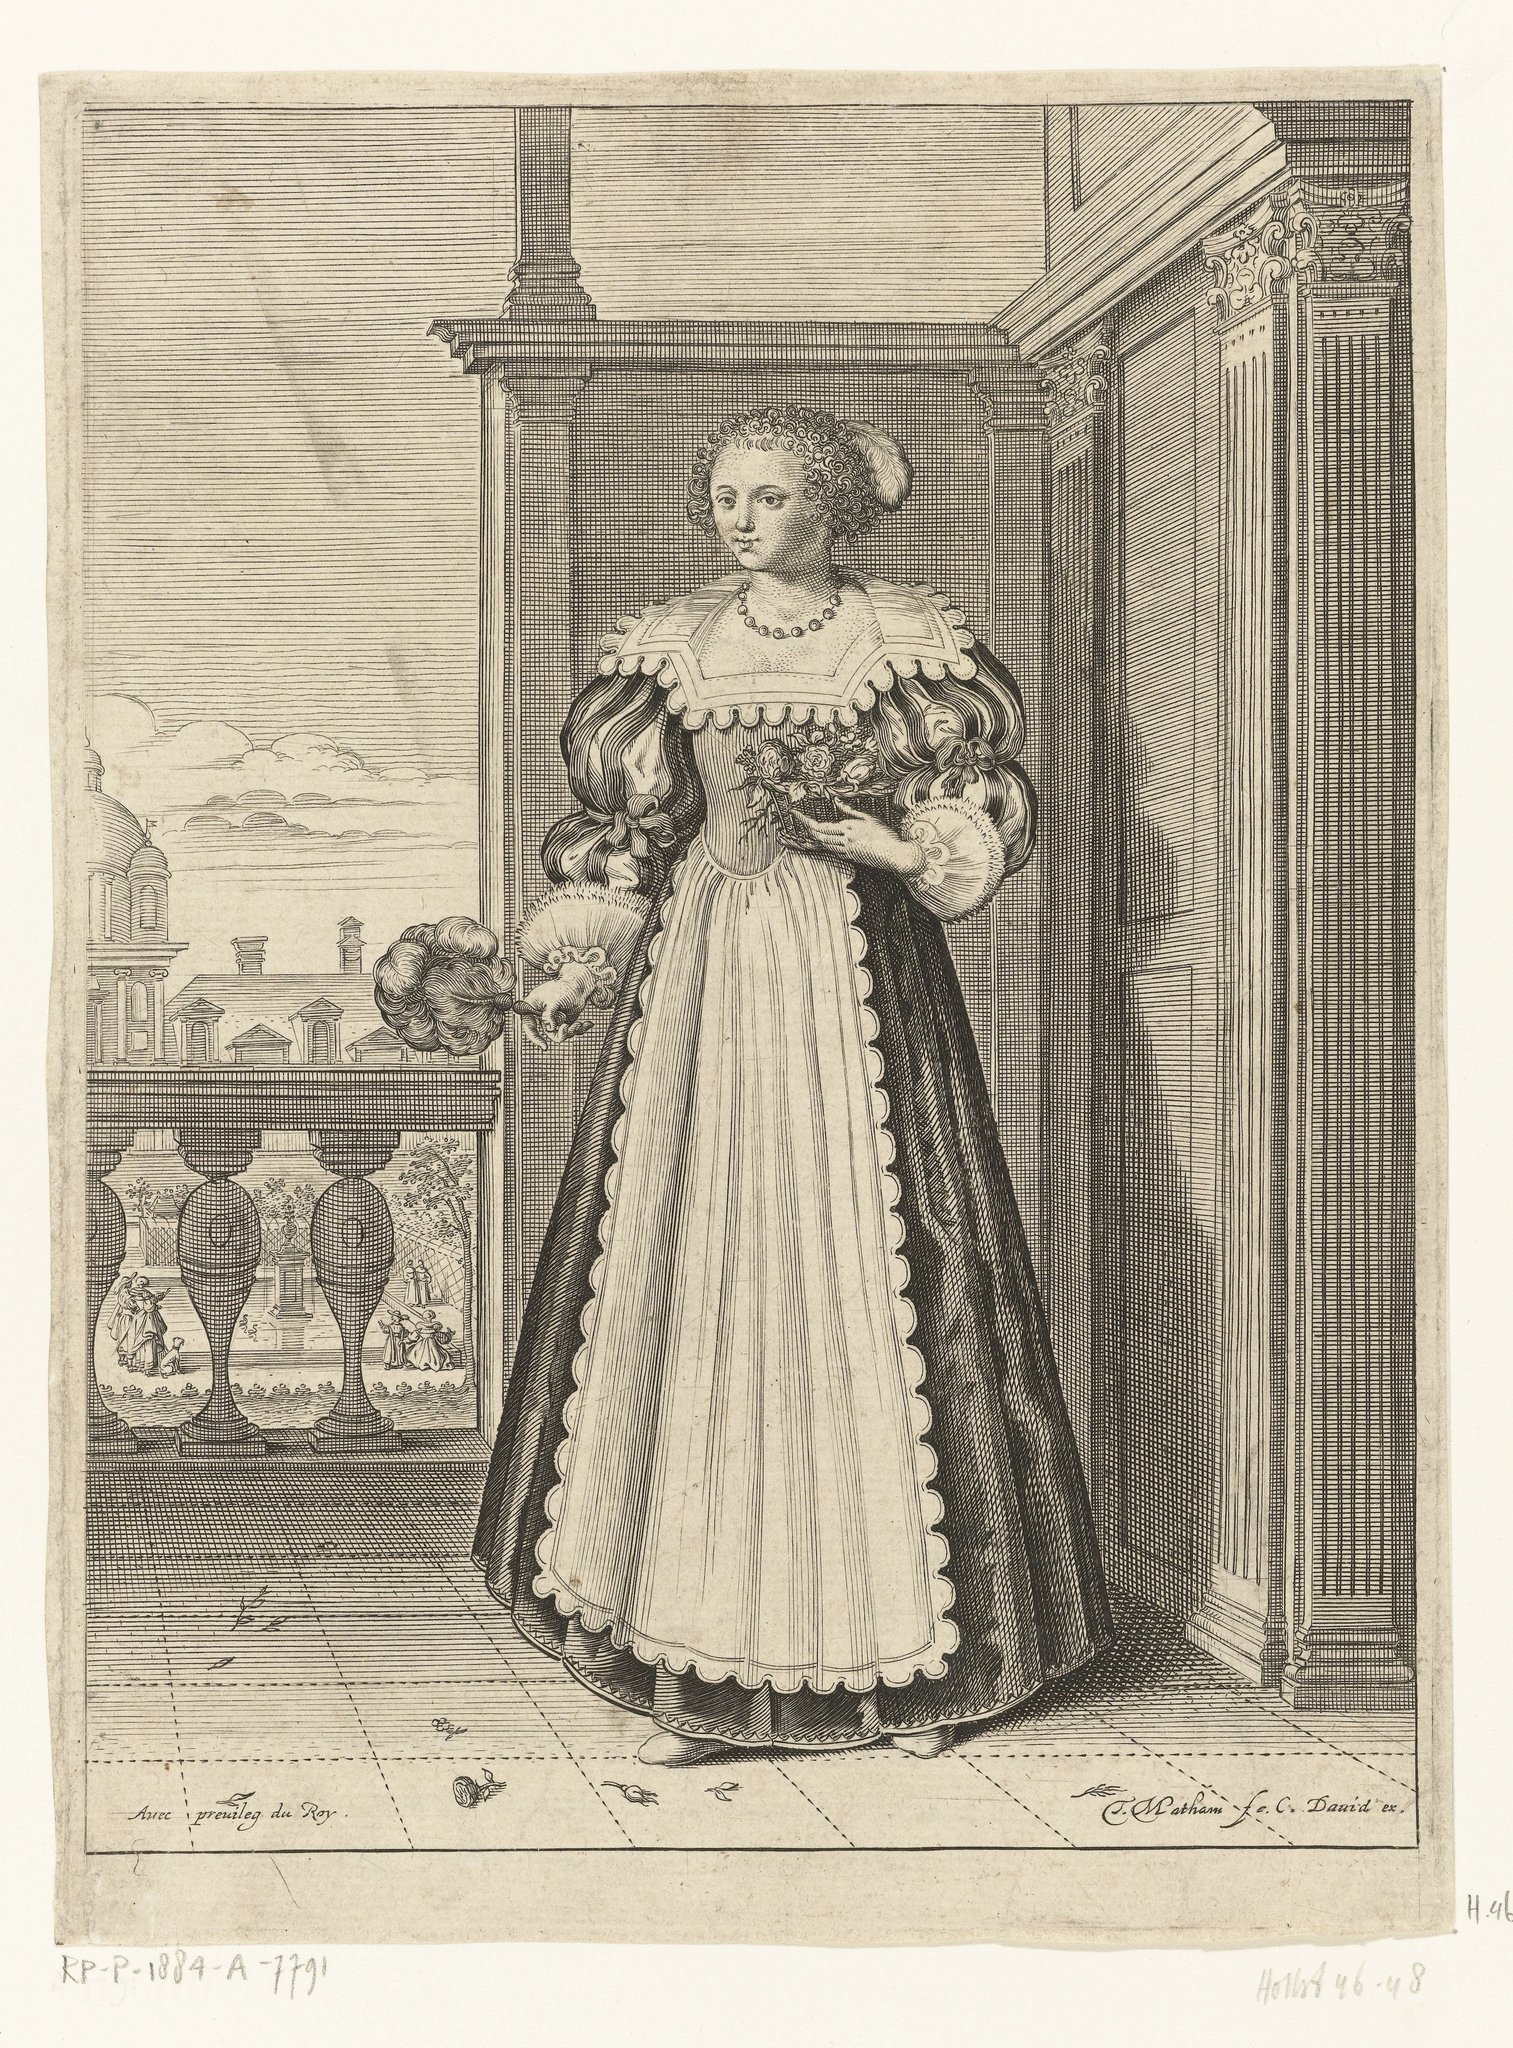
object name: print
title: Vrouw met waaier en bloemenmand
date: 1627-1629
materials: paper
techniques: engraving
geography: paris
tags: flowers, dress, gown (+ women's clothes), fan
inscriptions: privilege: ‘Avec privilegde du Roy’, address: ‘C. david ex.’, signature: ‘T.Matham fe.’, collector's mark: Lugt 2228, inscription: ‘1e staat voor hte onderschrift en met het 1ste adres van David. met het onderschrift en met het adres van Le Blond ex. achter Mathams naam bij Schneevoogt’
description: Een vrouw met waaier en bloemenmandje, staand op een bordes. Ze is gekleed in een japon met kanten kraag, waarvoor een schort. Zij draagt een ketting om de hals en een kort krullend kapsel met een veer.